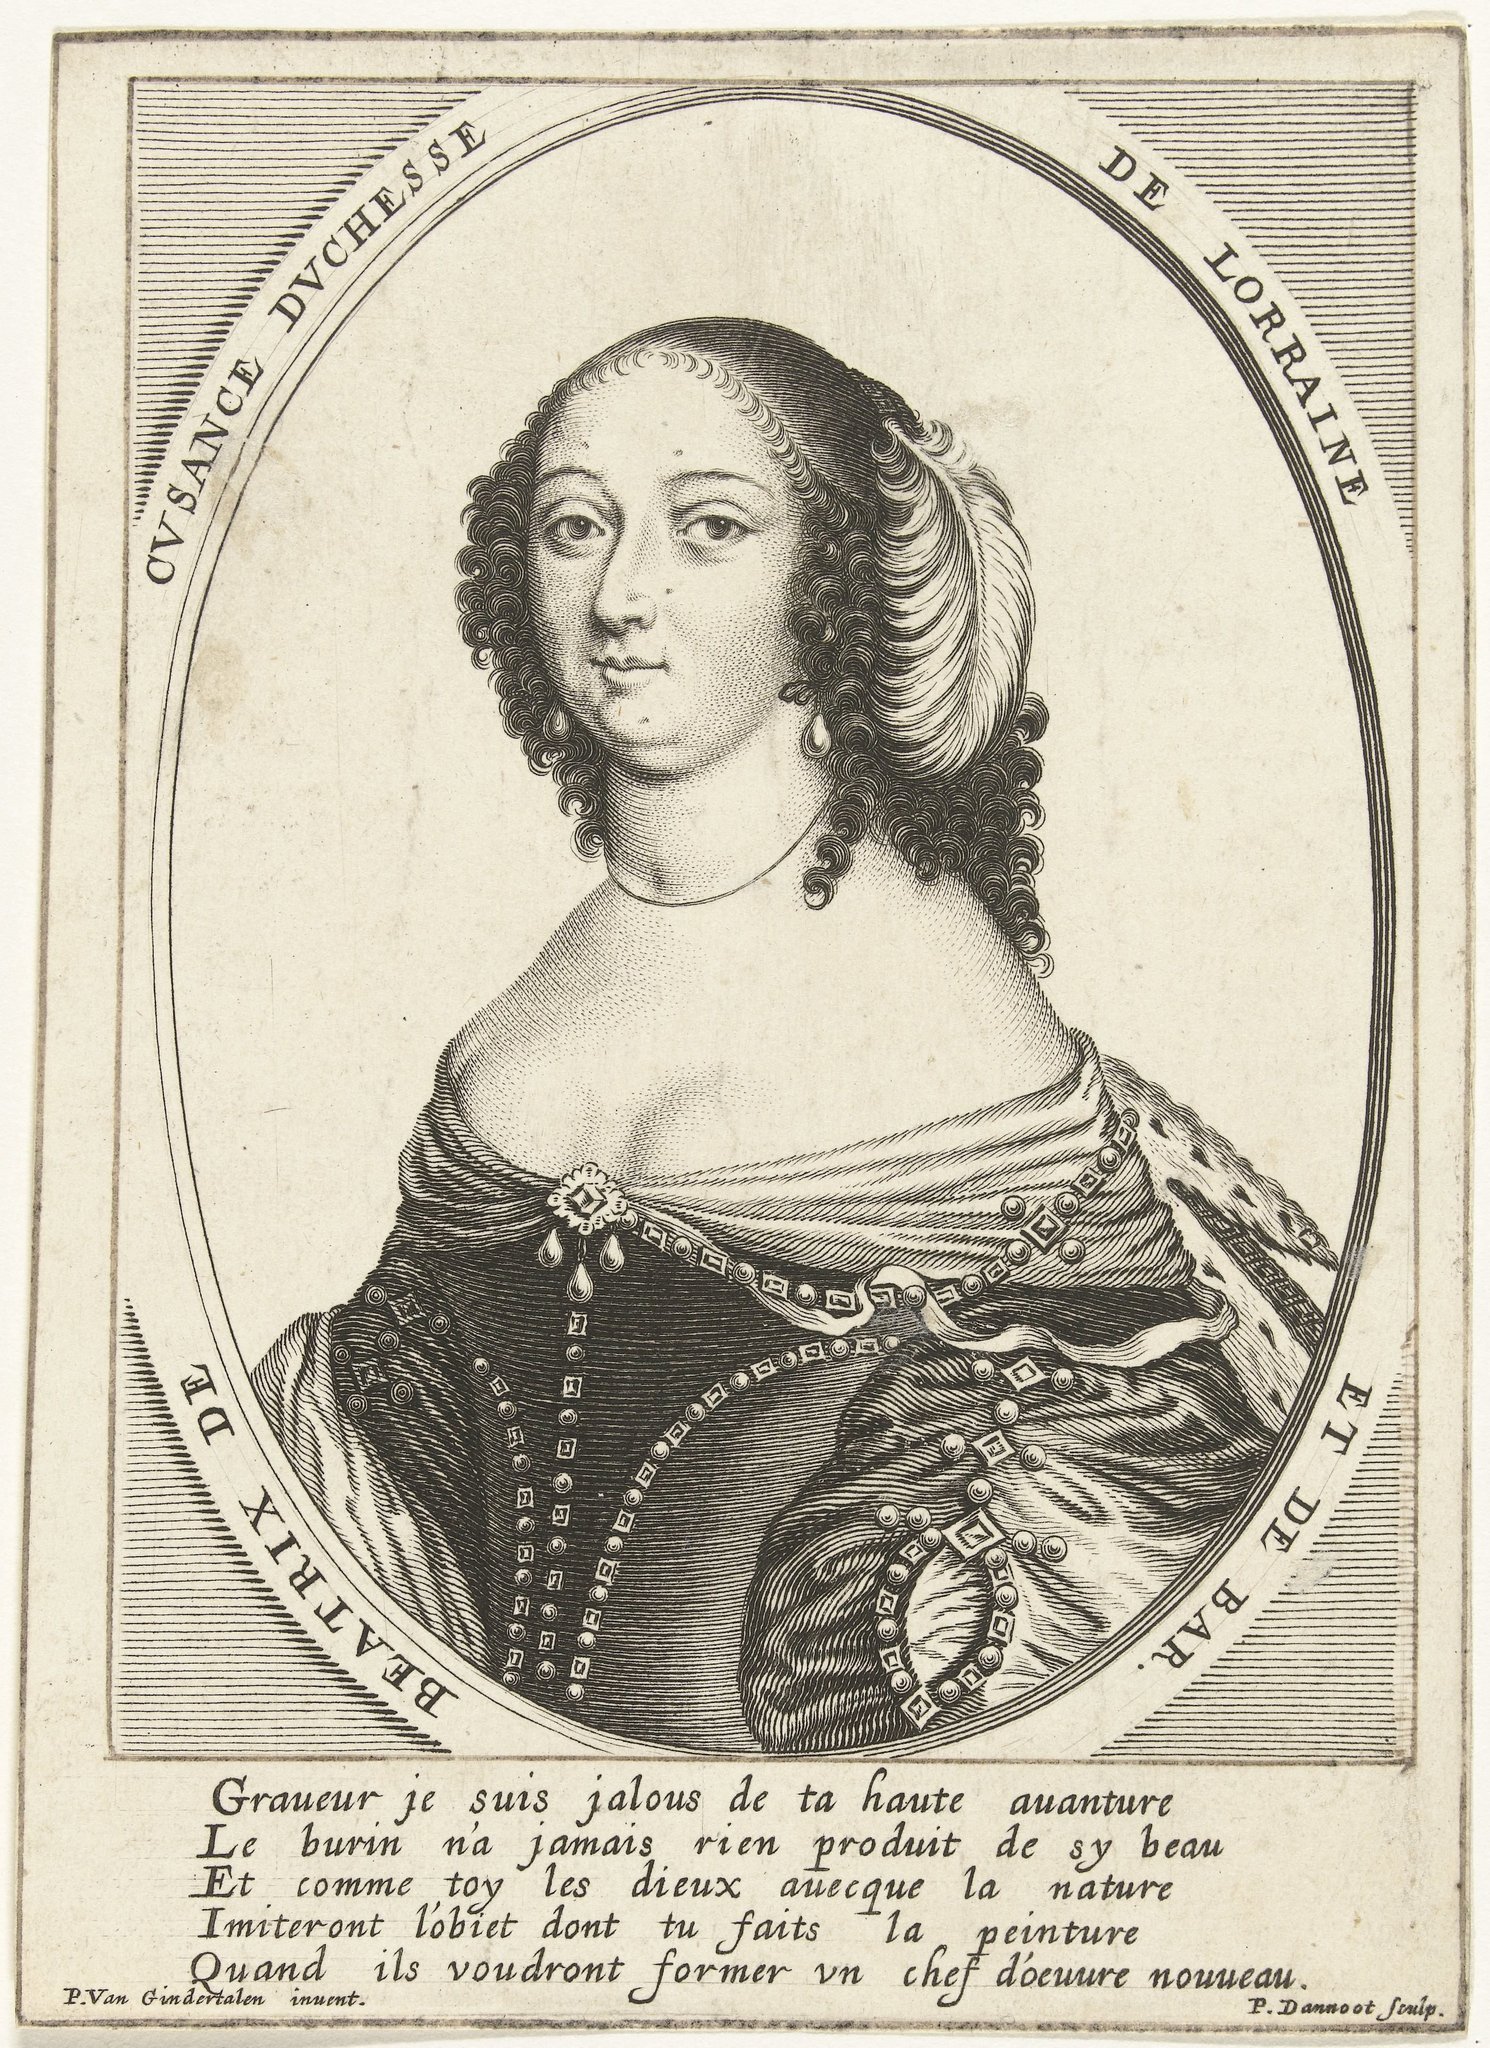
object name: print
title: Portret van Béatrix Cusance, hertogin van Lorraine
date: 1644-1692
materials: paper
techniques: engraving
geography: antwerp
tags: béatrix cusance (hertogin van lorraine)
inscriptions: collector's mark: Lugt 2228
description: Portret van Béatrix Cusance, hertogin van Lorraine, in ovaal, gekleed in jurk met lage open hals en veer op haar hoofd. In ondermarge Frans vers in vijf regels.